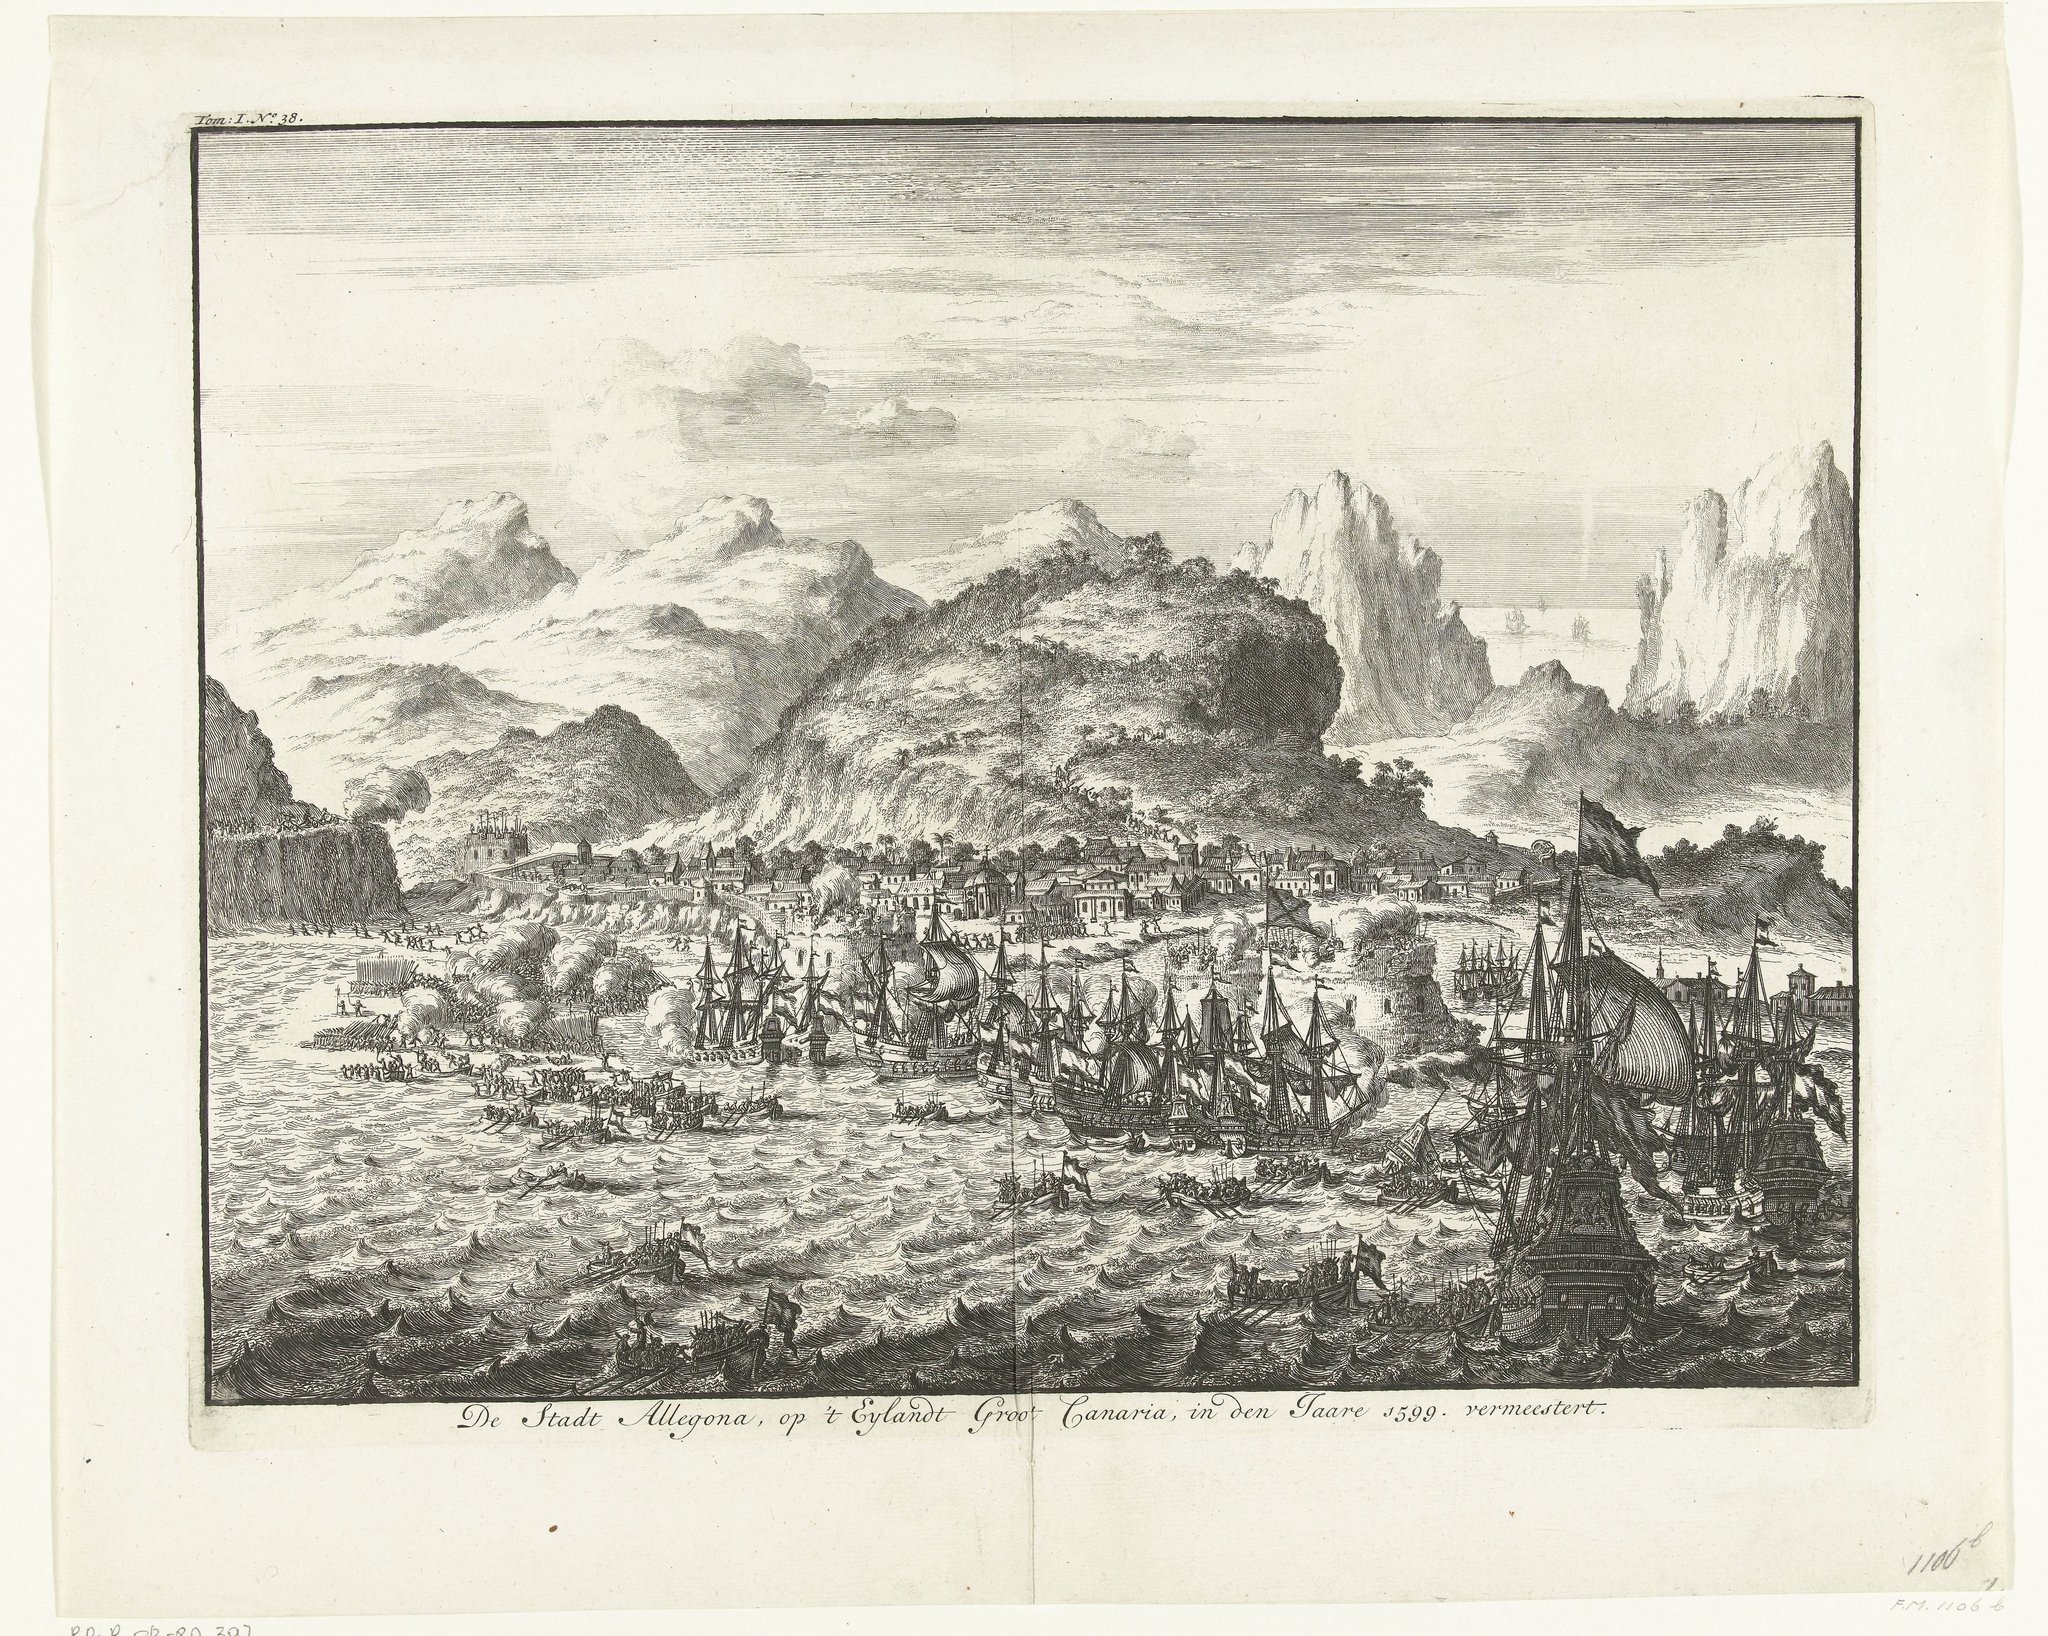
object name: print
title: De Stadt Allegona, op 't Eylandt Groot Canaria, in den Jaare 1599. vermeestert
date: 1682-1684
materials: paper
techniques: engraving, etching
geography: northern netherlands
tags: battle (+ naval force)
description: Gebruikt als illustratie in: J. le Clerc, Geschiedenissen der Vereenigde Nederlanden, sedert den aanvang van die Republyk tot op den Vrede van Utrecht in 't jaar 1713 en het Tractaat van Barriere in 't jaar 1715 gesloten, Z. Chatelain, Amsterdam 1730, 3 delen, Tom. I, No. 38.